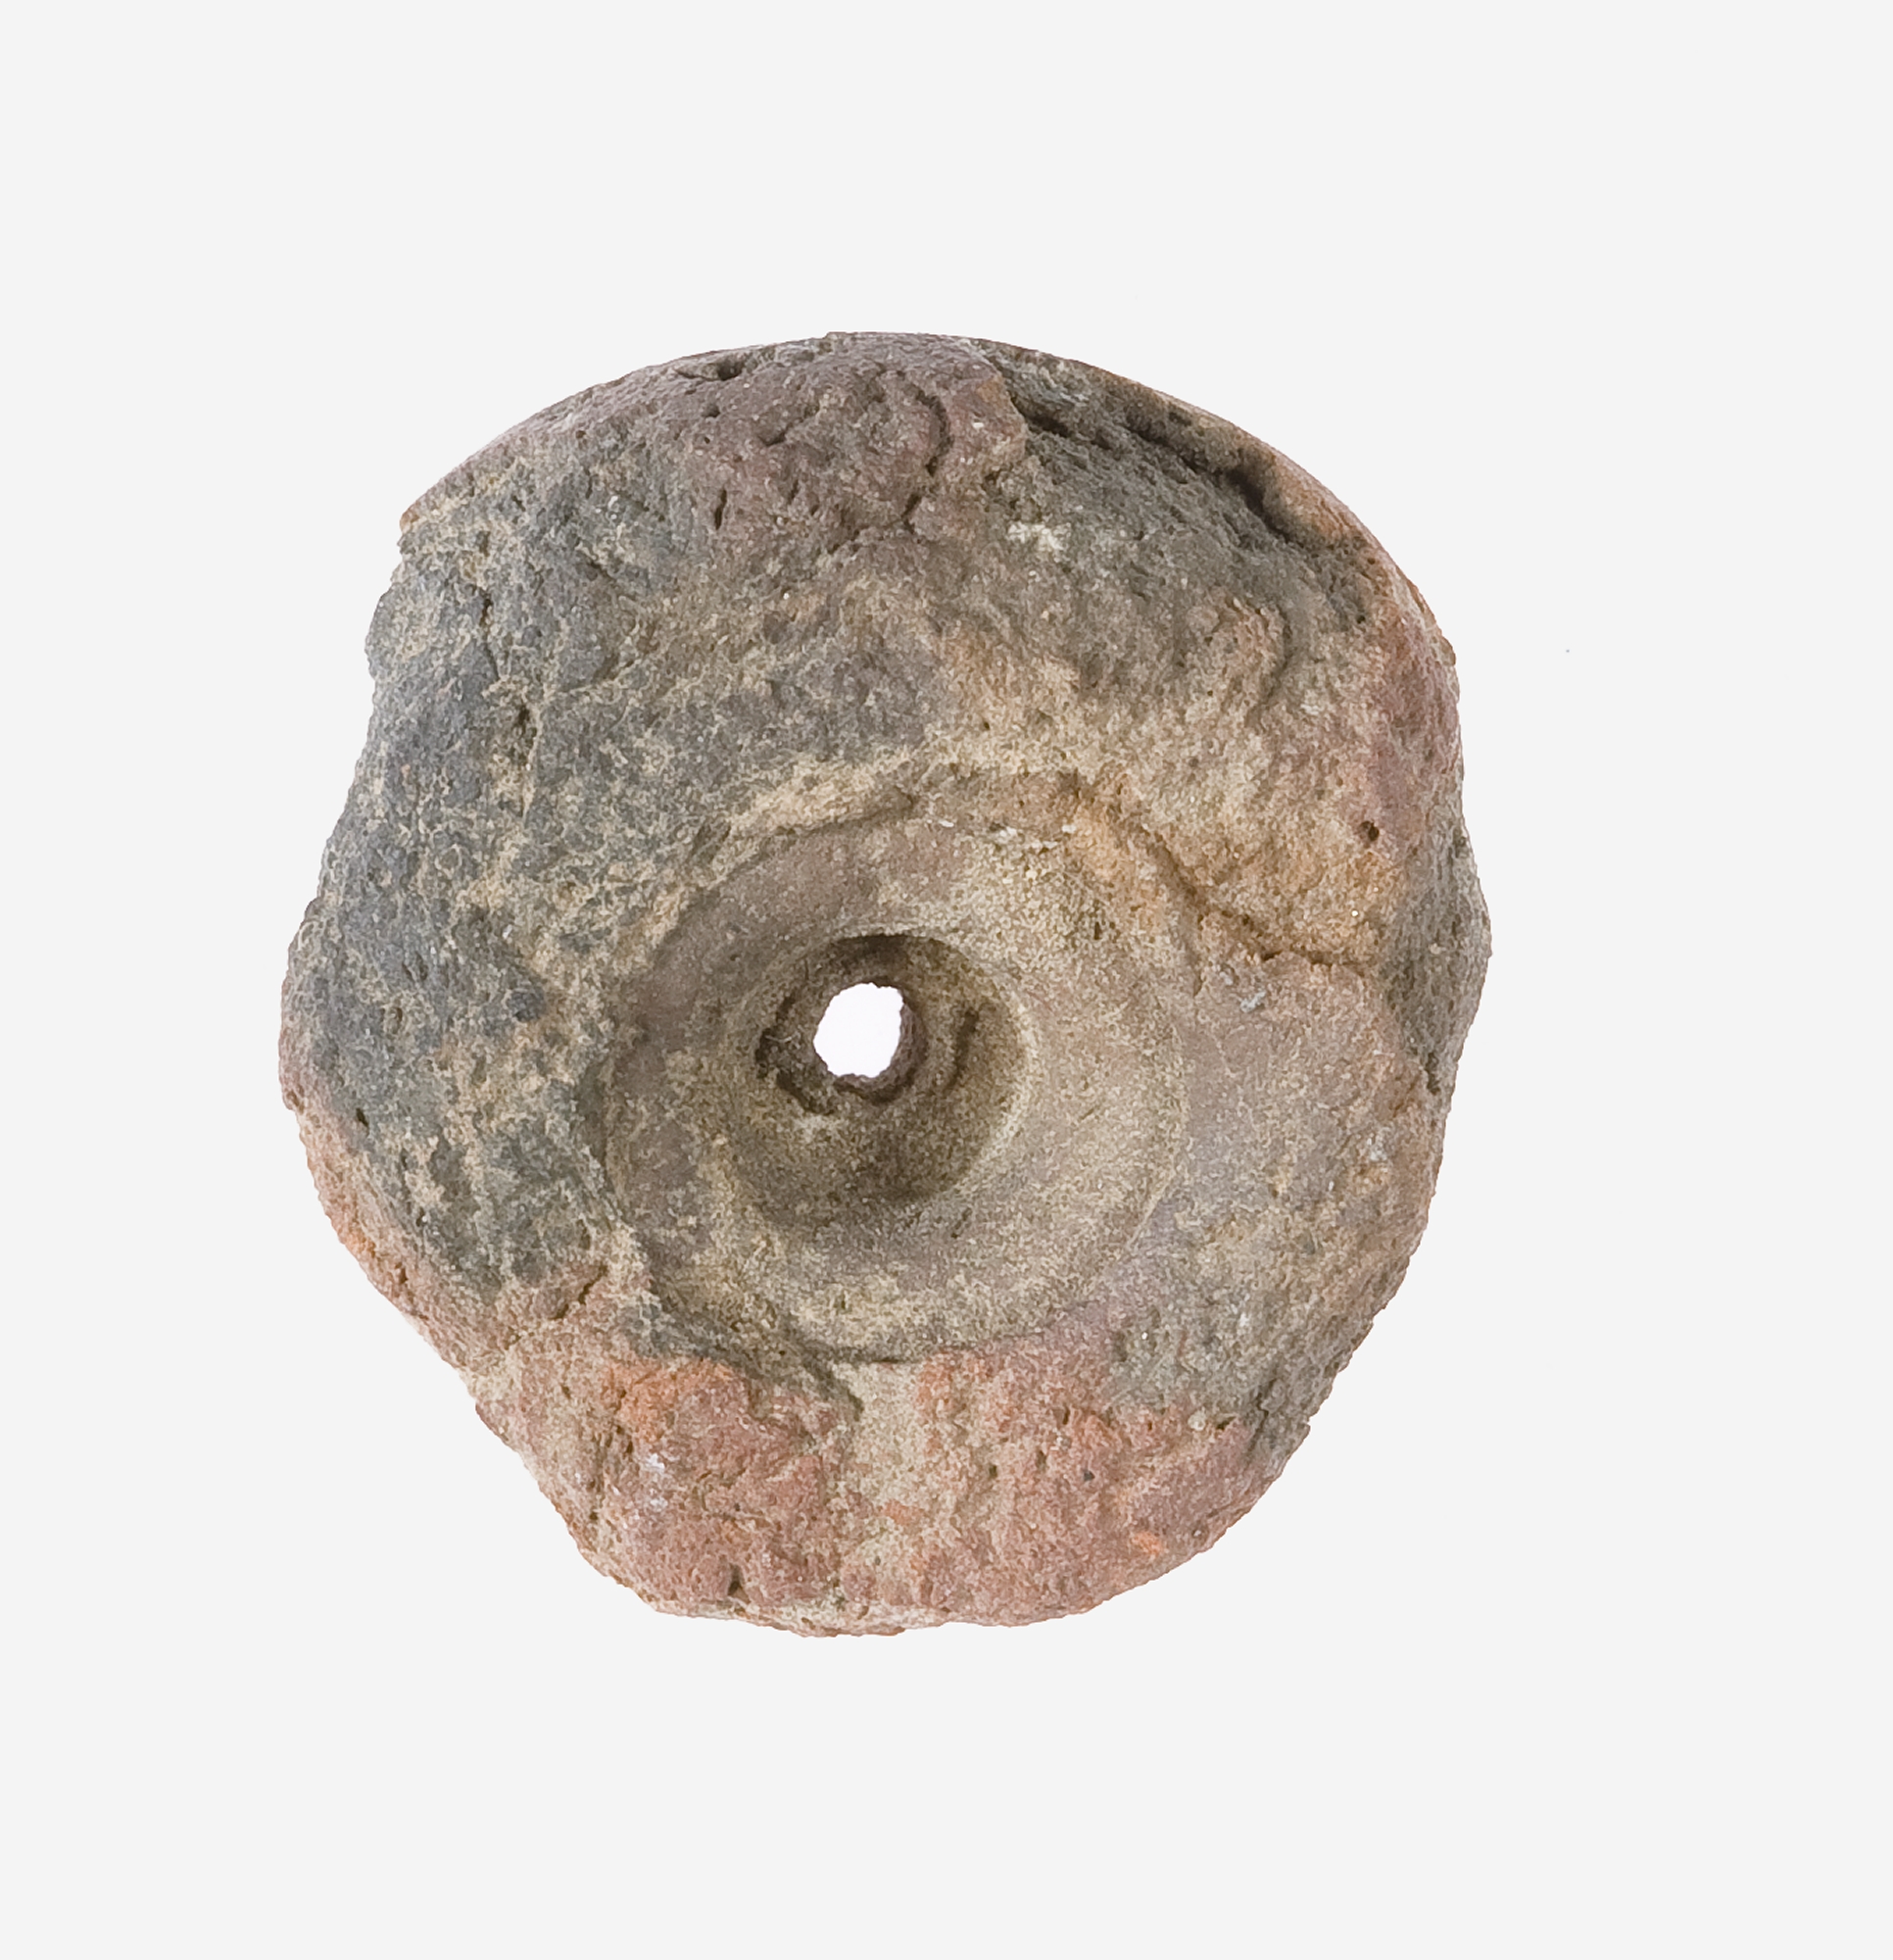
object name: mold, cornflower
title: Ridged Umbel Mold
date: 1390-1352 BCE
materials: pottery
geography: egypt